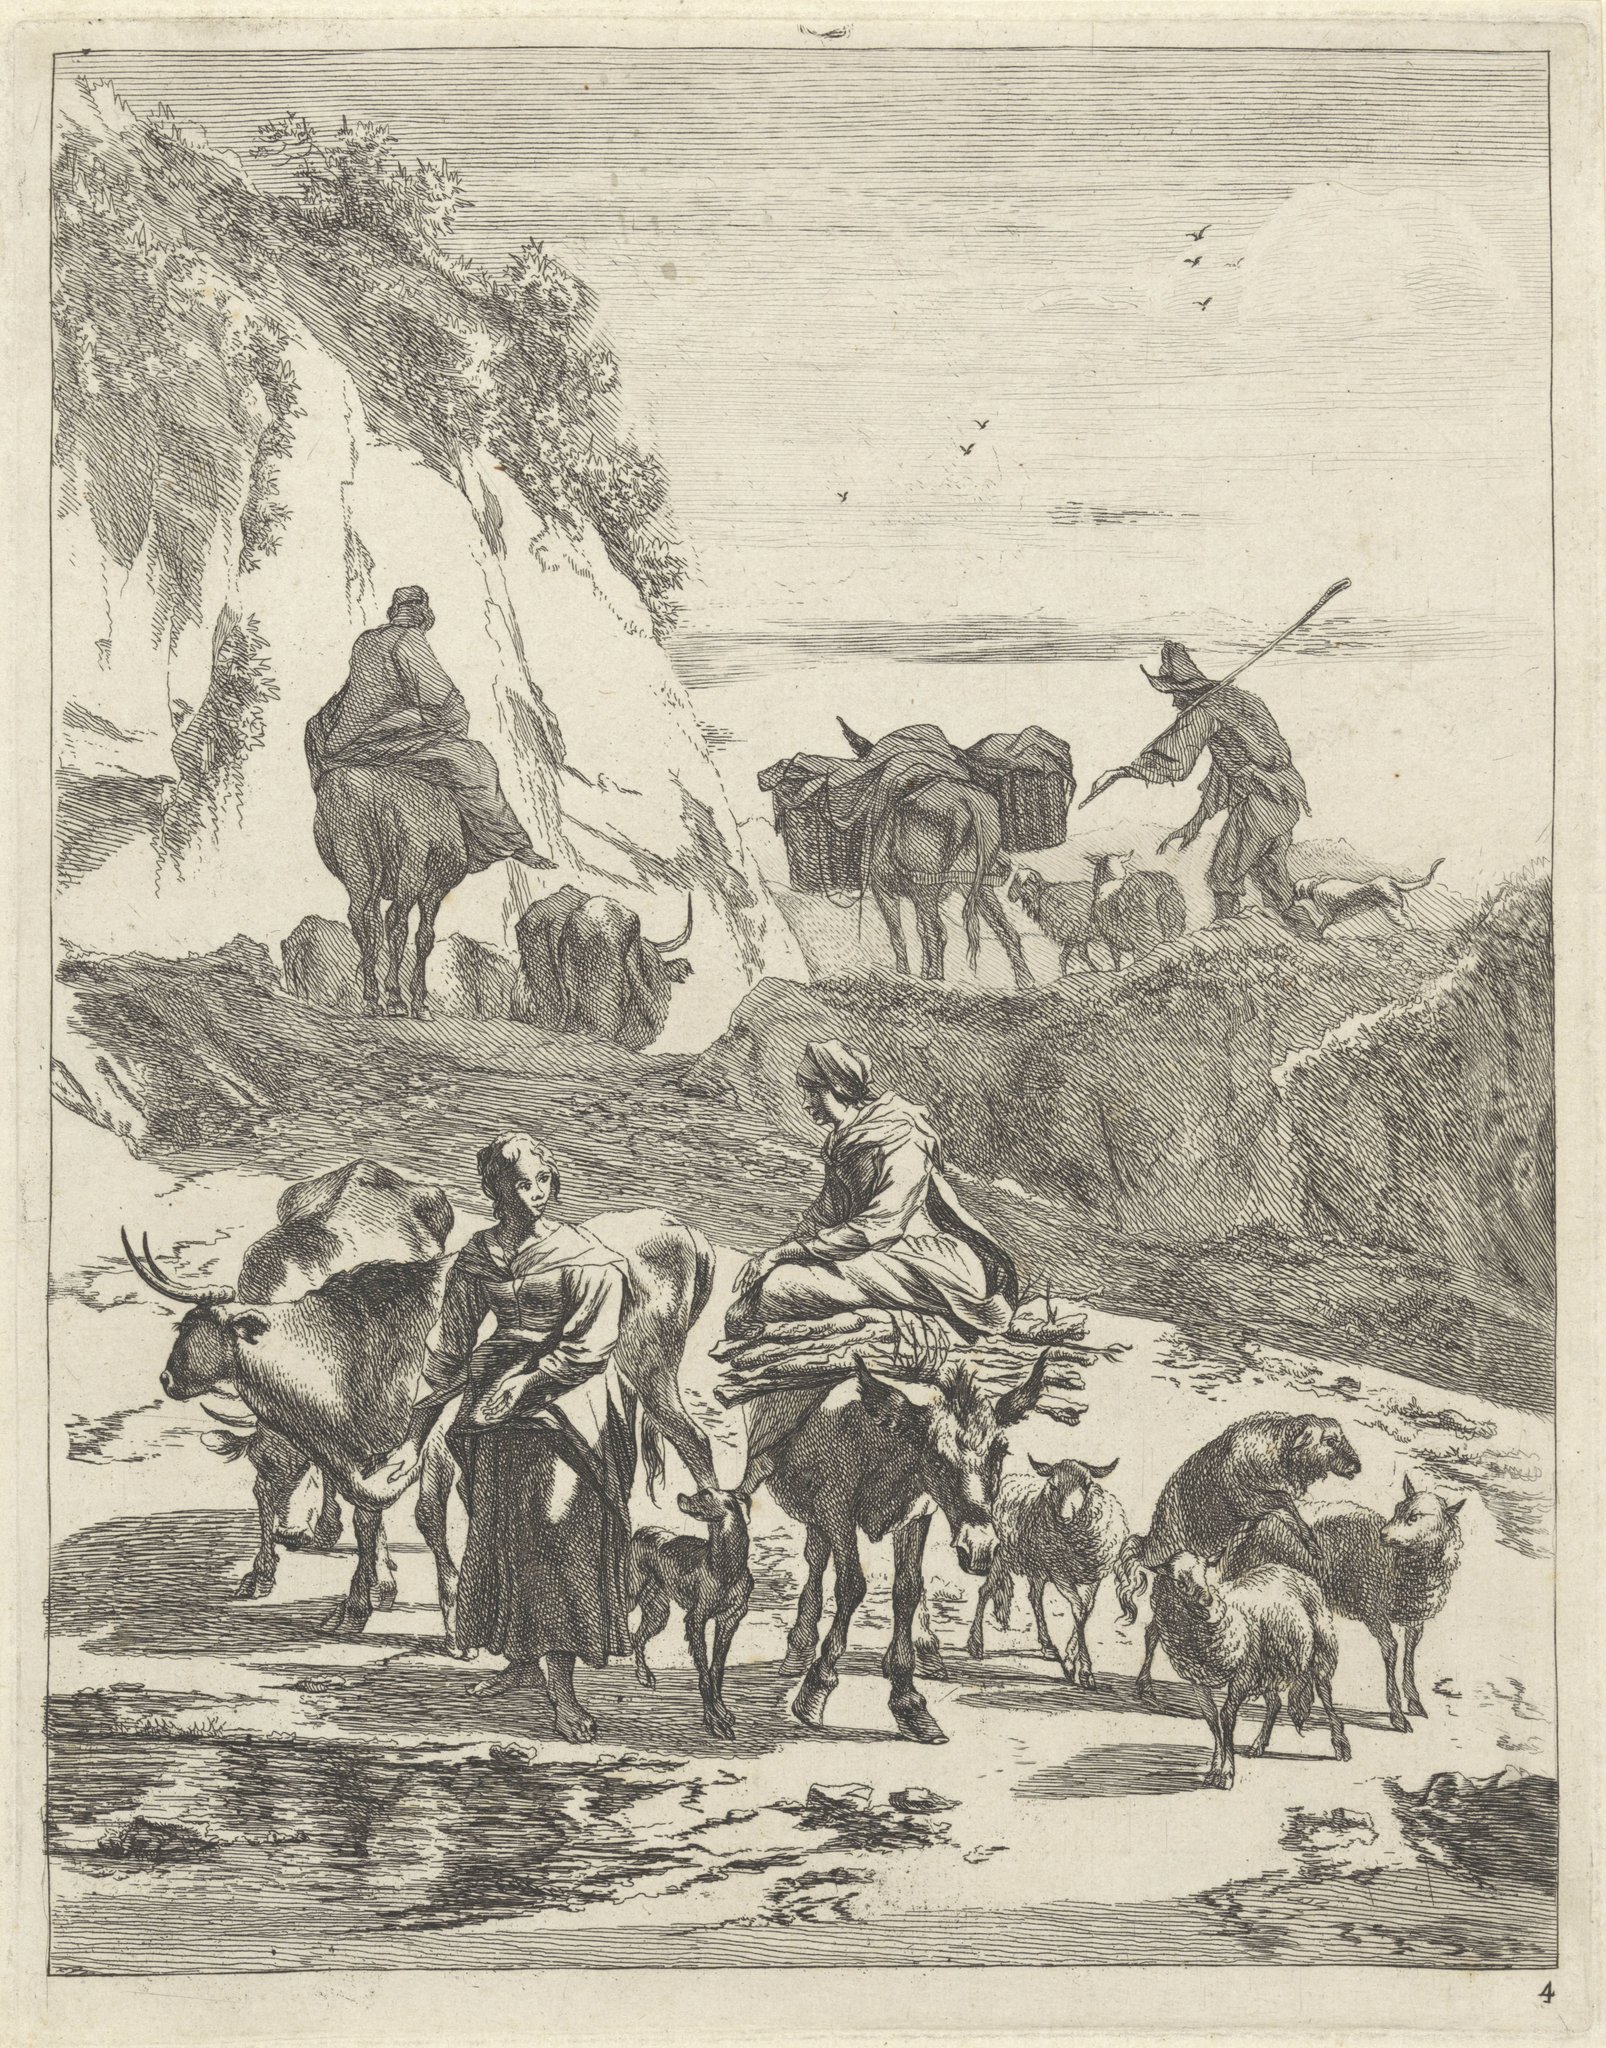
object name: print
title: Pastorale landschappen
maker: jan de visscher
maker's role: print maker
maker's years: 1633-1712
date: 1650-1701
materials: paper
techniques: engraving, etching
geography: northern netherlands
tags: riding a horse, ass, or mule; rider, horseman, herding, herdsman, herdswoman, shepherd, shepherdess, cowherd, etc., ford, rocks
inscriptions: collector's mark: Lugt 240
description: Twee herderinnen staan met hun kudde schapen en koeien bij een doorwaadbare plek in het gebergte. Op de achtergrond twee herders met hun vee.